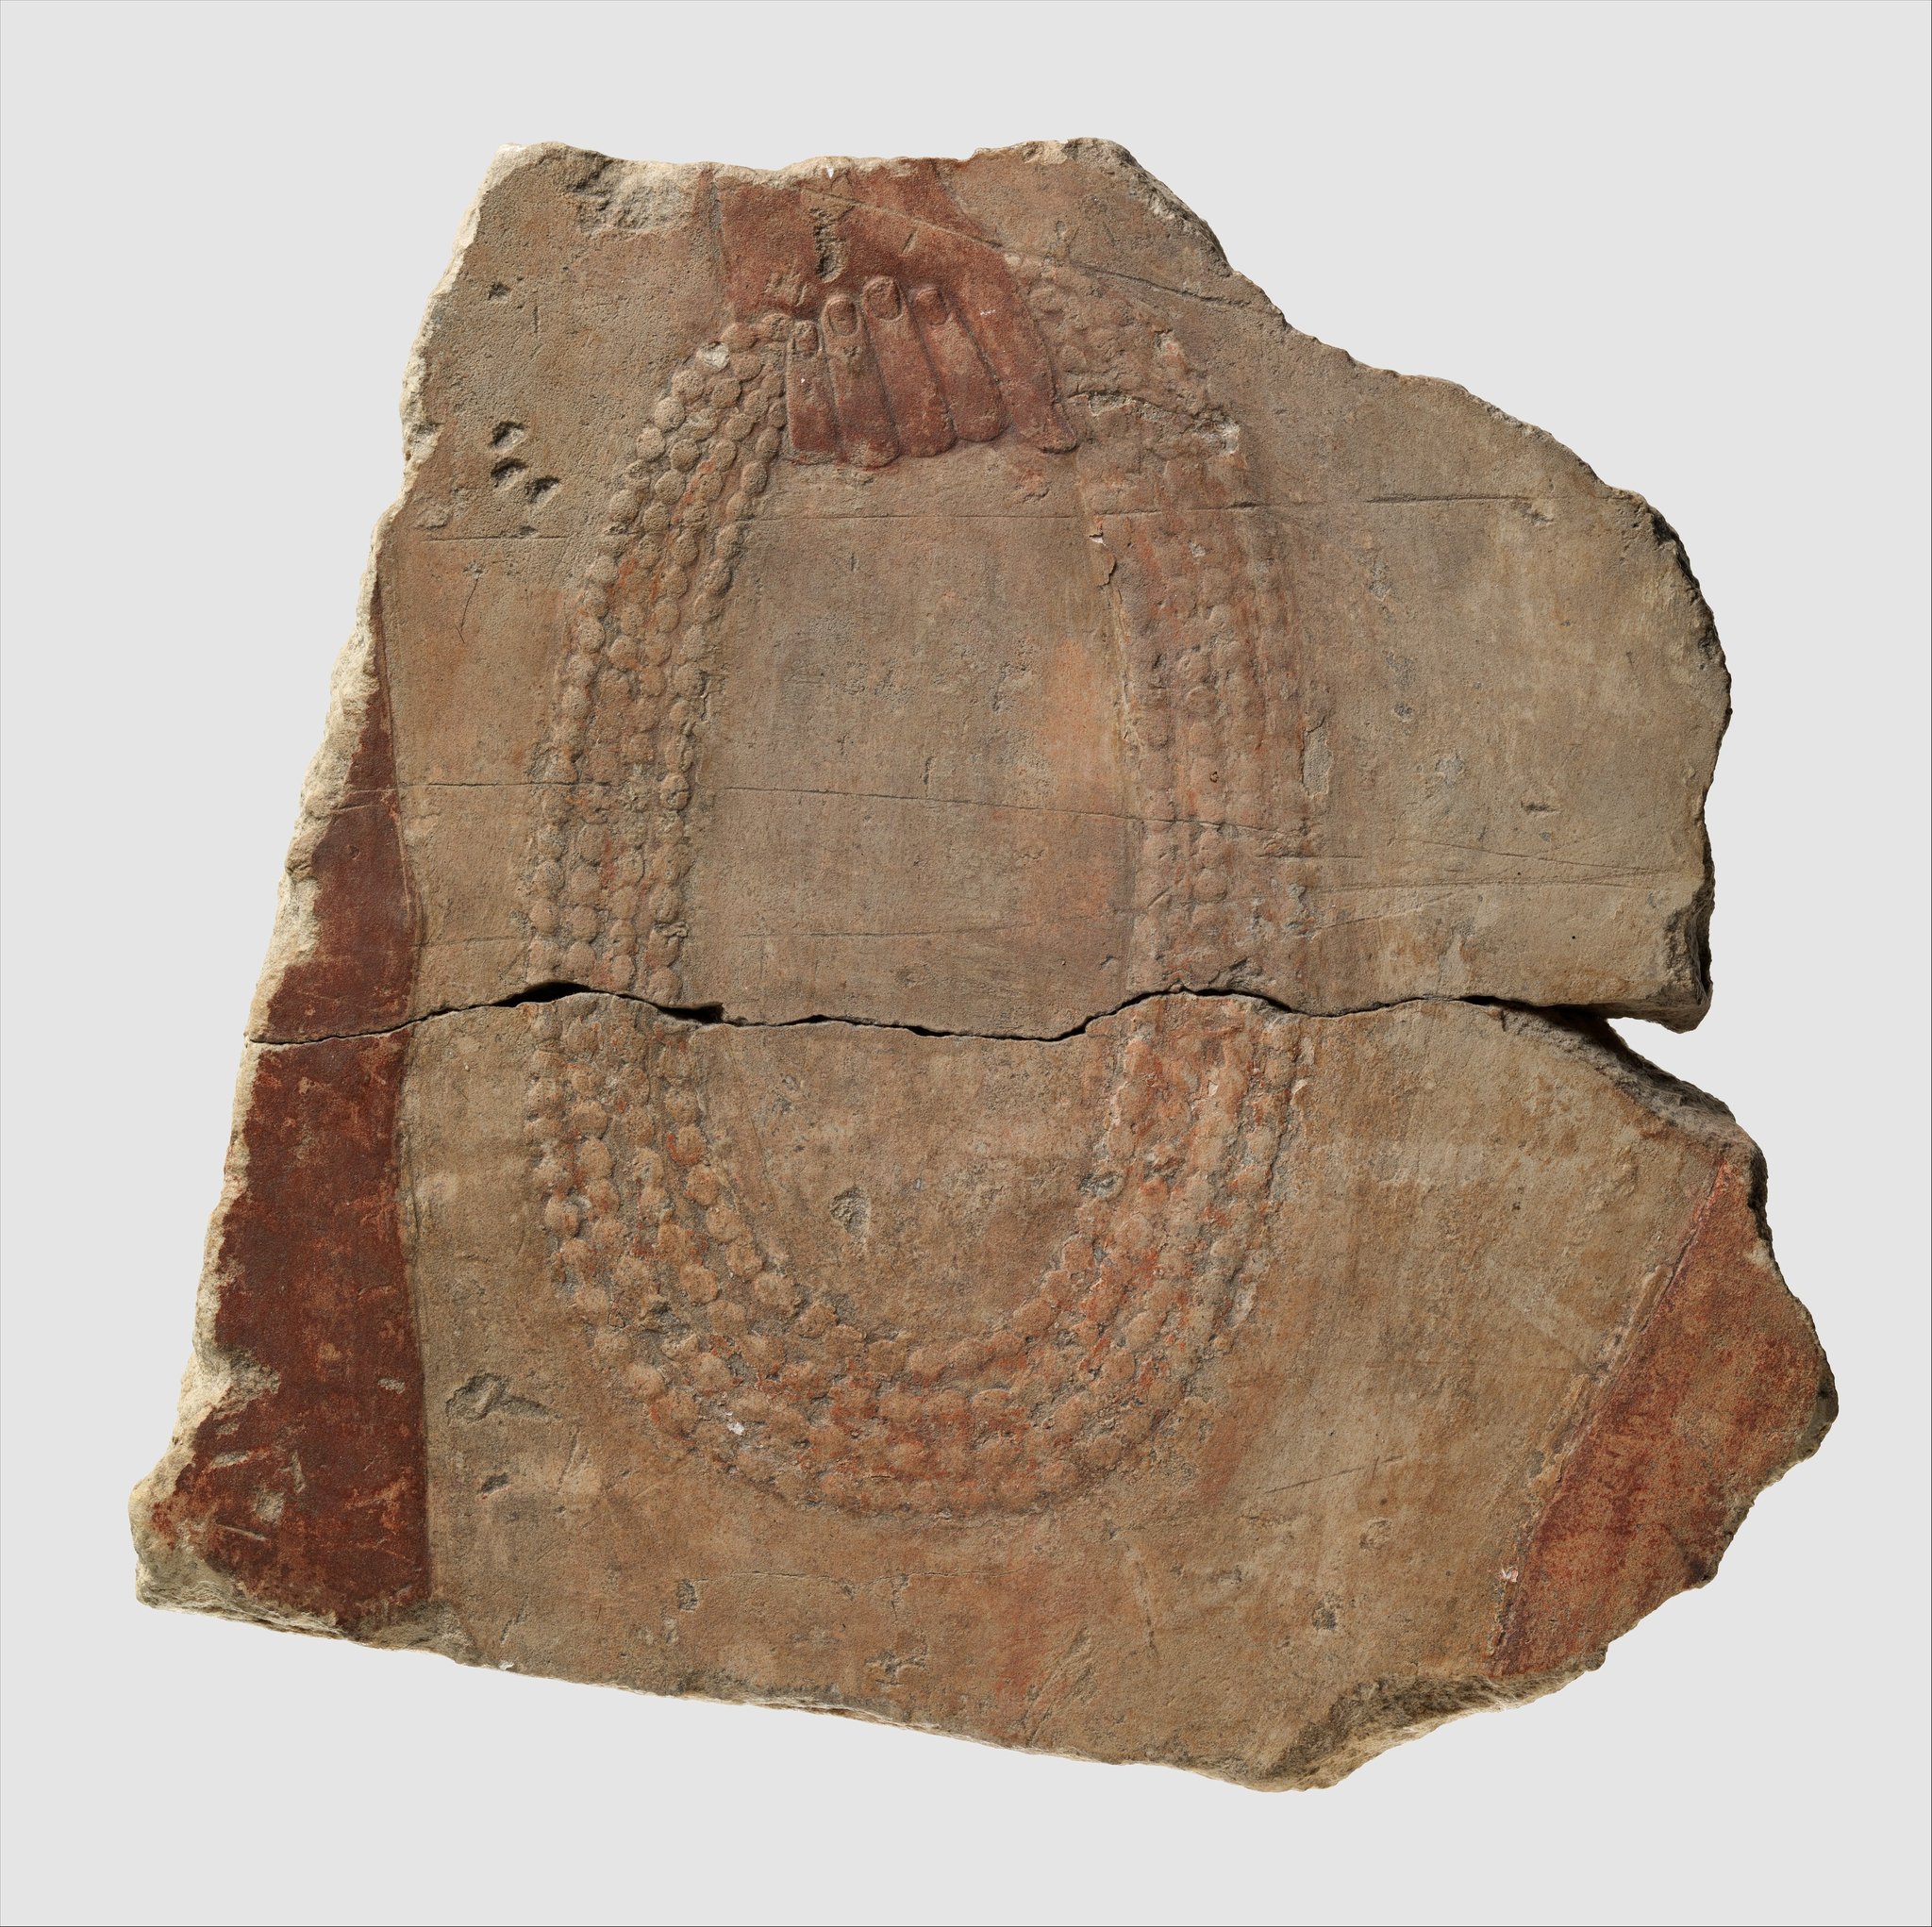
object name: relief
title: Fragment of a figure holding a multistrand coil of beads, preceded by another individual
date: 1961-1917 BCE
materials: limestone, paint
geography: egypt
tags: hands